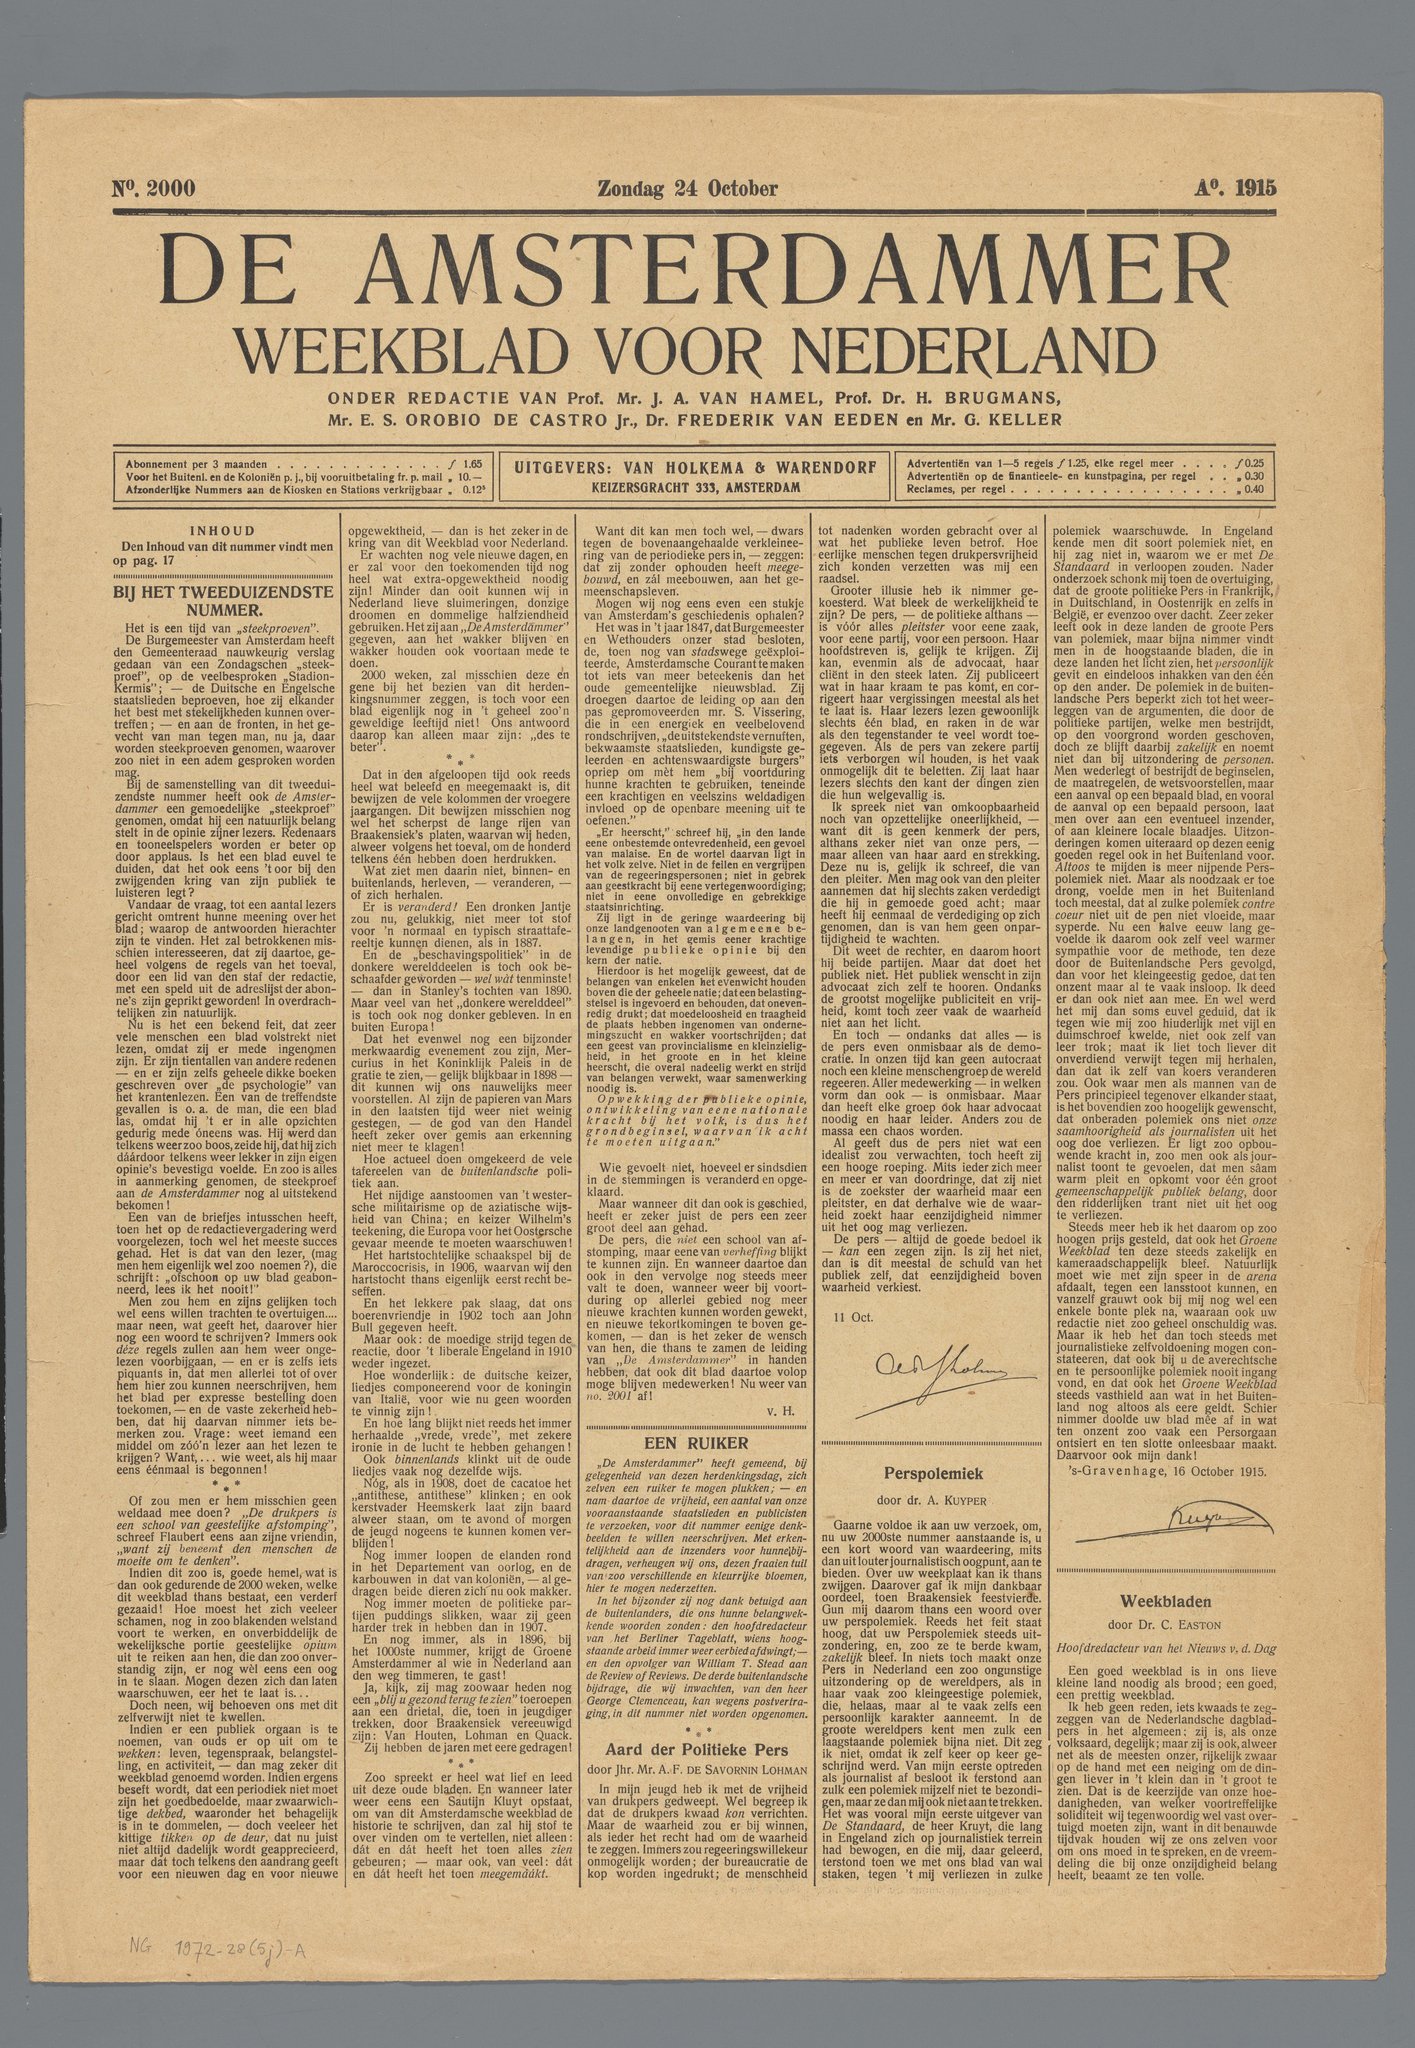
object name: newspaper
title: De Amsterdammer weekblad voor Nederland, No. 2000, 24 oktober 1915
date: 1915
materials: paper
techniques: printing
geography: amsterdam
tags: amsterdam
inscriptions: date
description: Krant, bestaande uit drie katernen en in totaal 26 genummerde pp.